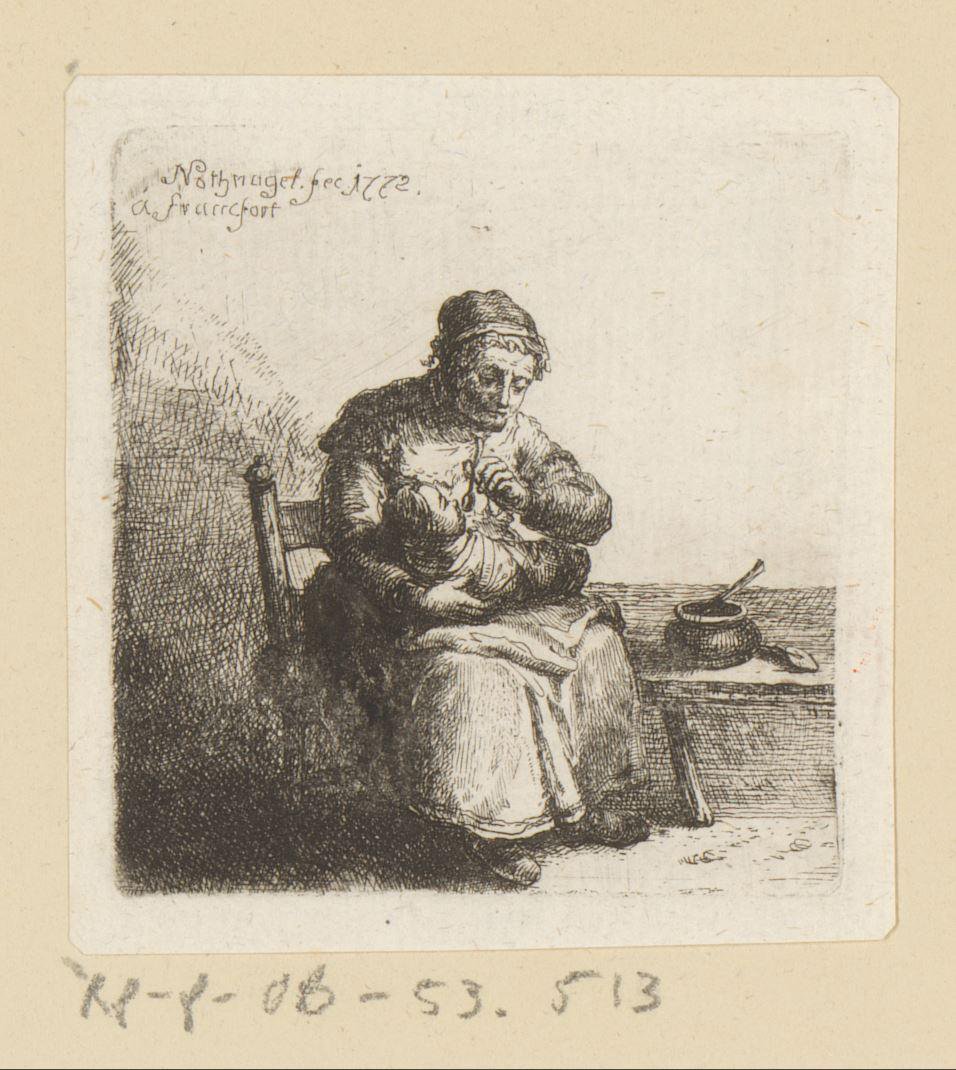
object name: print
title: Vrouw voert ingebakerd kindje op haar schoot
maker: johann andreas benjamin nothnagel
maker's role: print maker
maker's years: 1729-1804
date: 1739-1804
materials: paper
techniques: etching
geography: frankfurt am main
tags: feeding a baby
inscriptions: collector's mark: Lugt 240